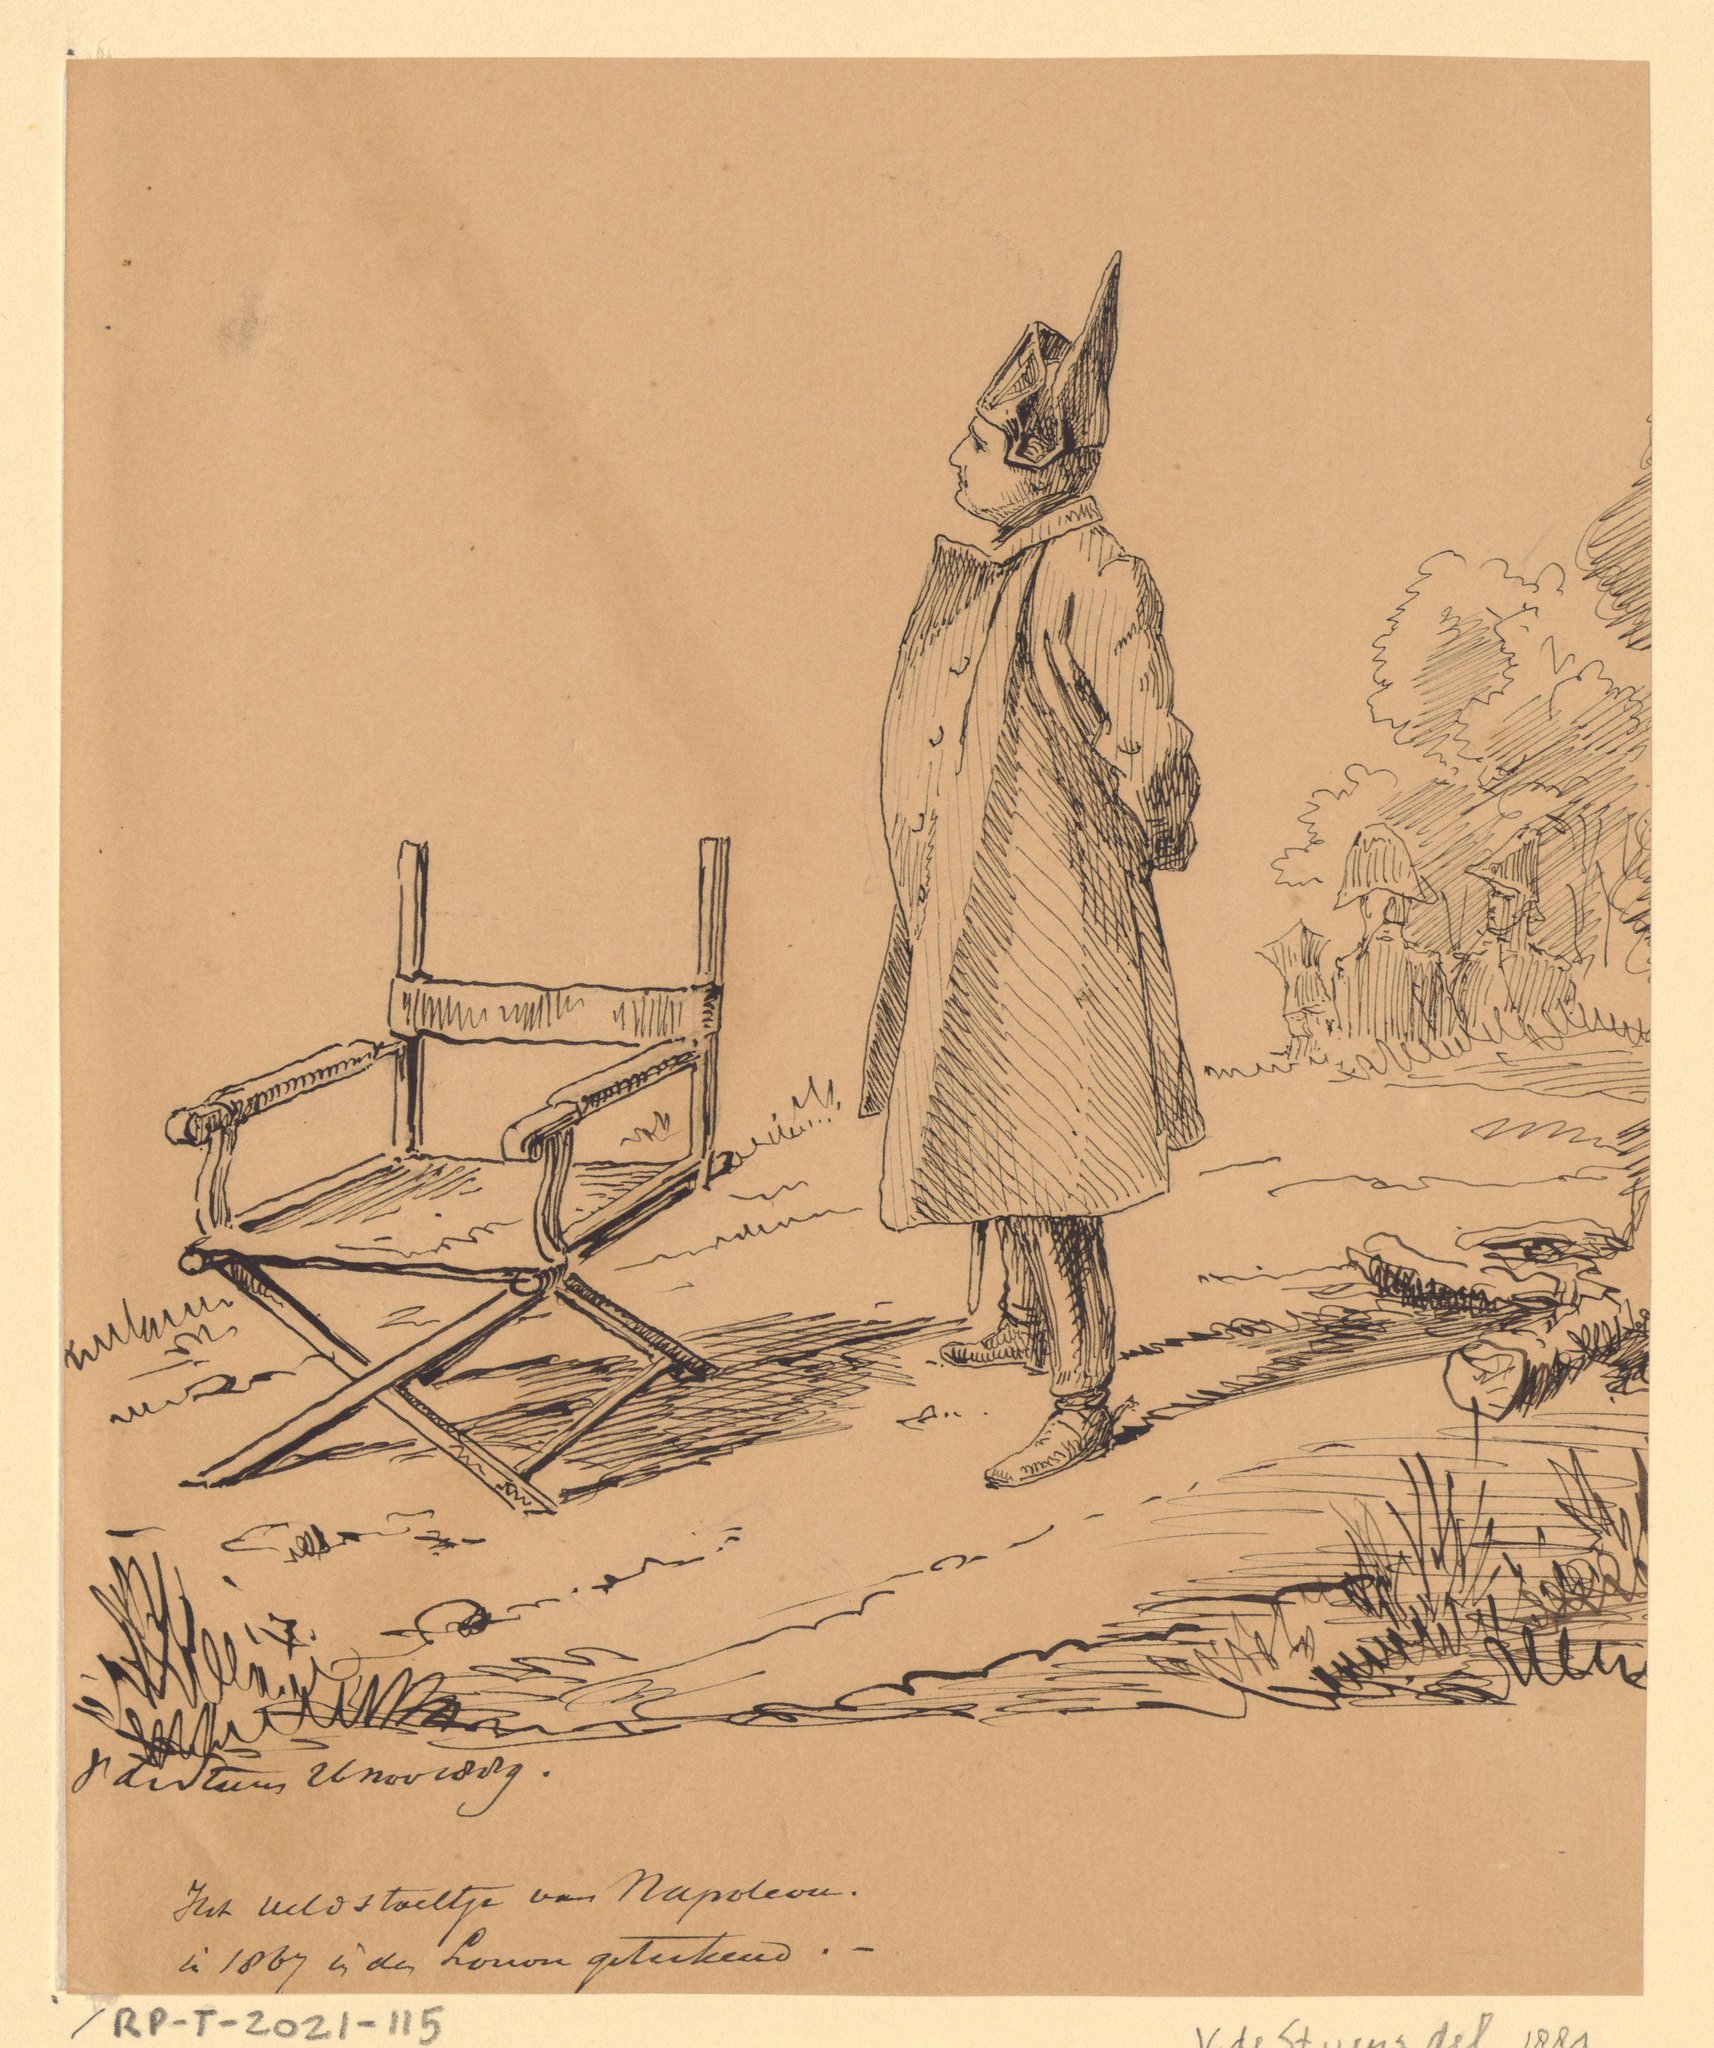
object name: drawing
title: Napoleon I Bonaparte staand naast een vouwstoel in een landschap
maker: victor de stuers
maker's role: politician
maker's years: 1843-1916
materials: ink, paper, pencil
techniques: pen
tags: napoleon i (emperor of the french), historical persons, emperor, chair